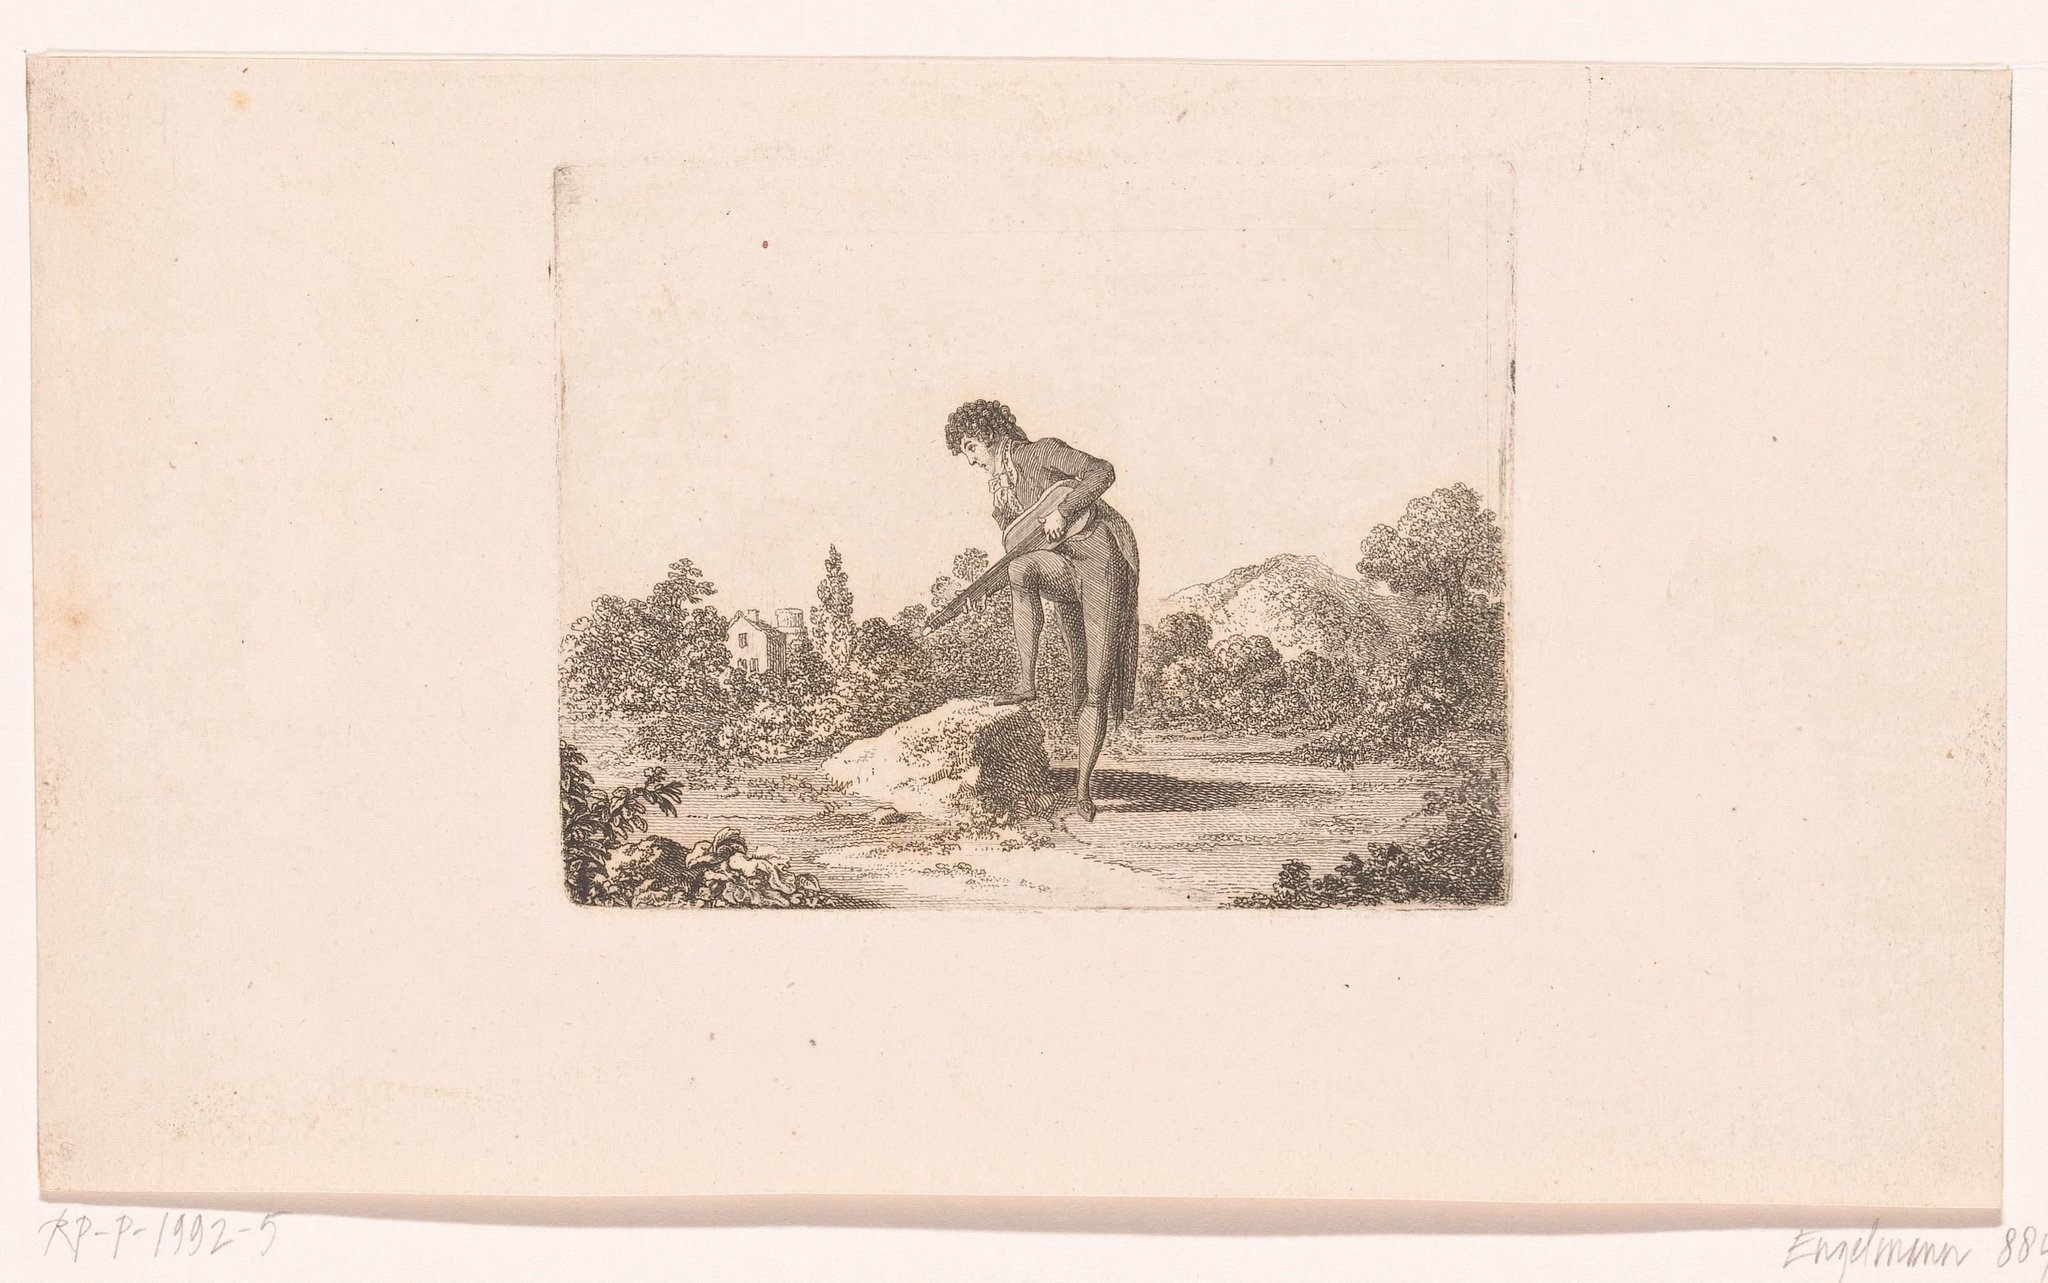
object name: print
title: Mr. de Vollange speelt op zijn gitaar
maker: daniel nikolaus chodowiecki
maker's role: draughtsman, print maker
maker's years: 1726-1801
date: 1798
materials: paper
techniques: etching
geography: berlin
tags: one person playing string instrument (plucked) - cc - out of doors, landscapes, actor (on the stage)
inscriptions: collector's mark: Lugt 2228